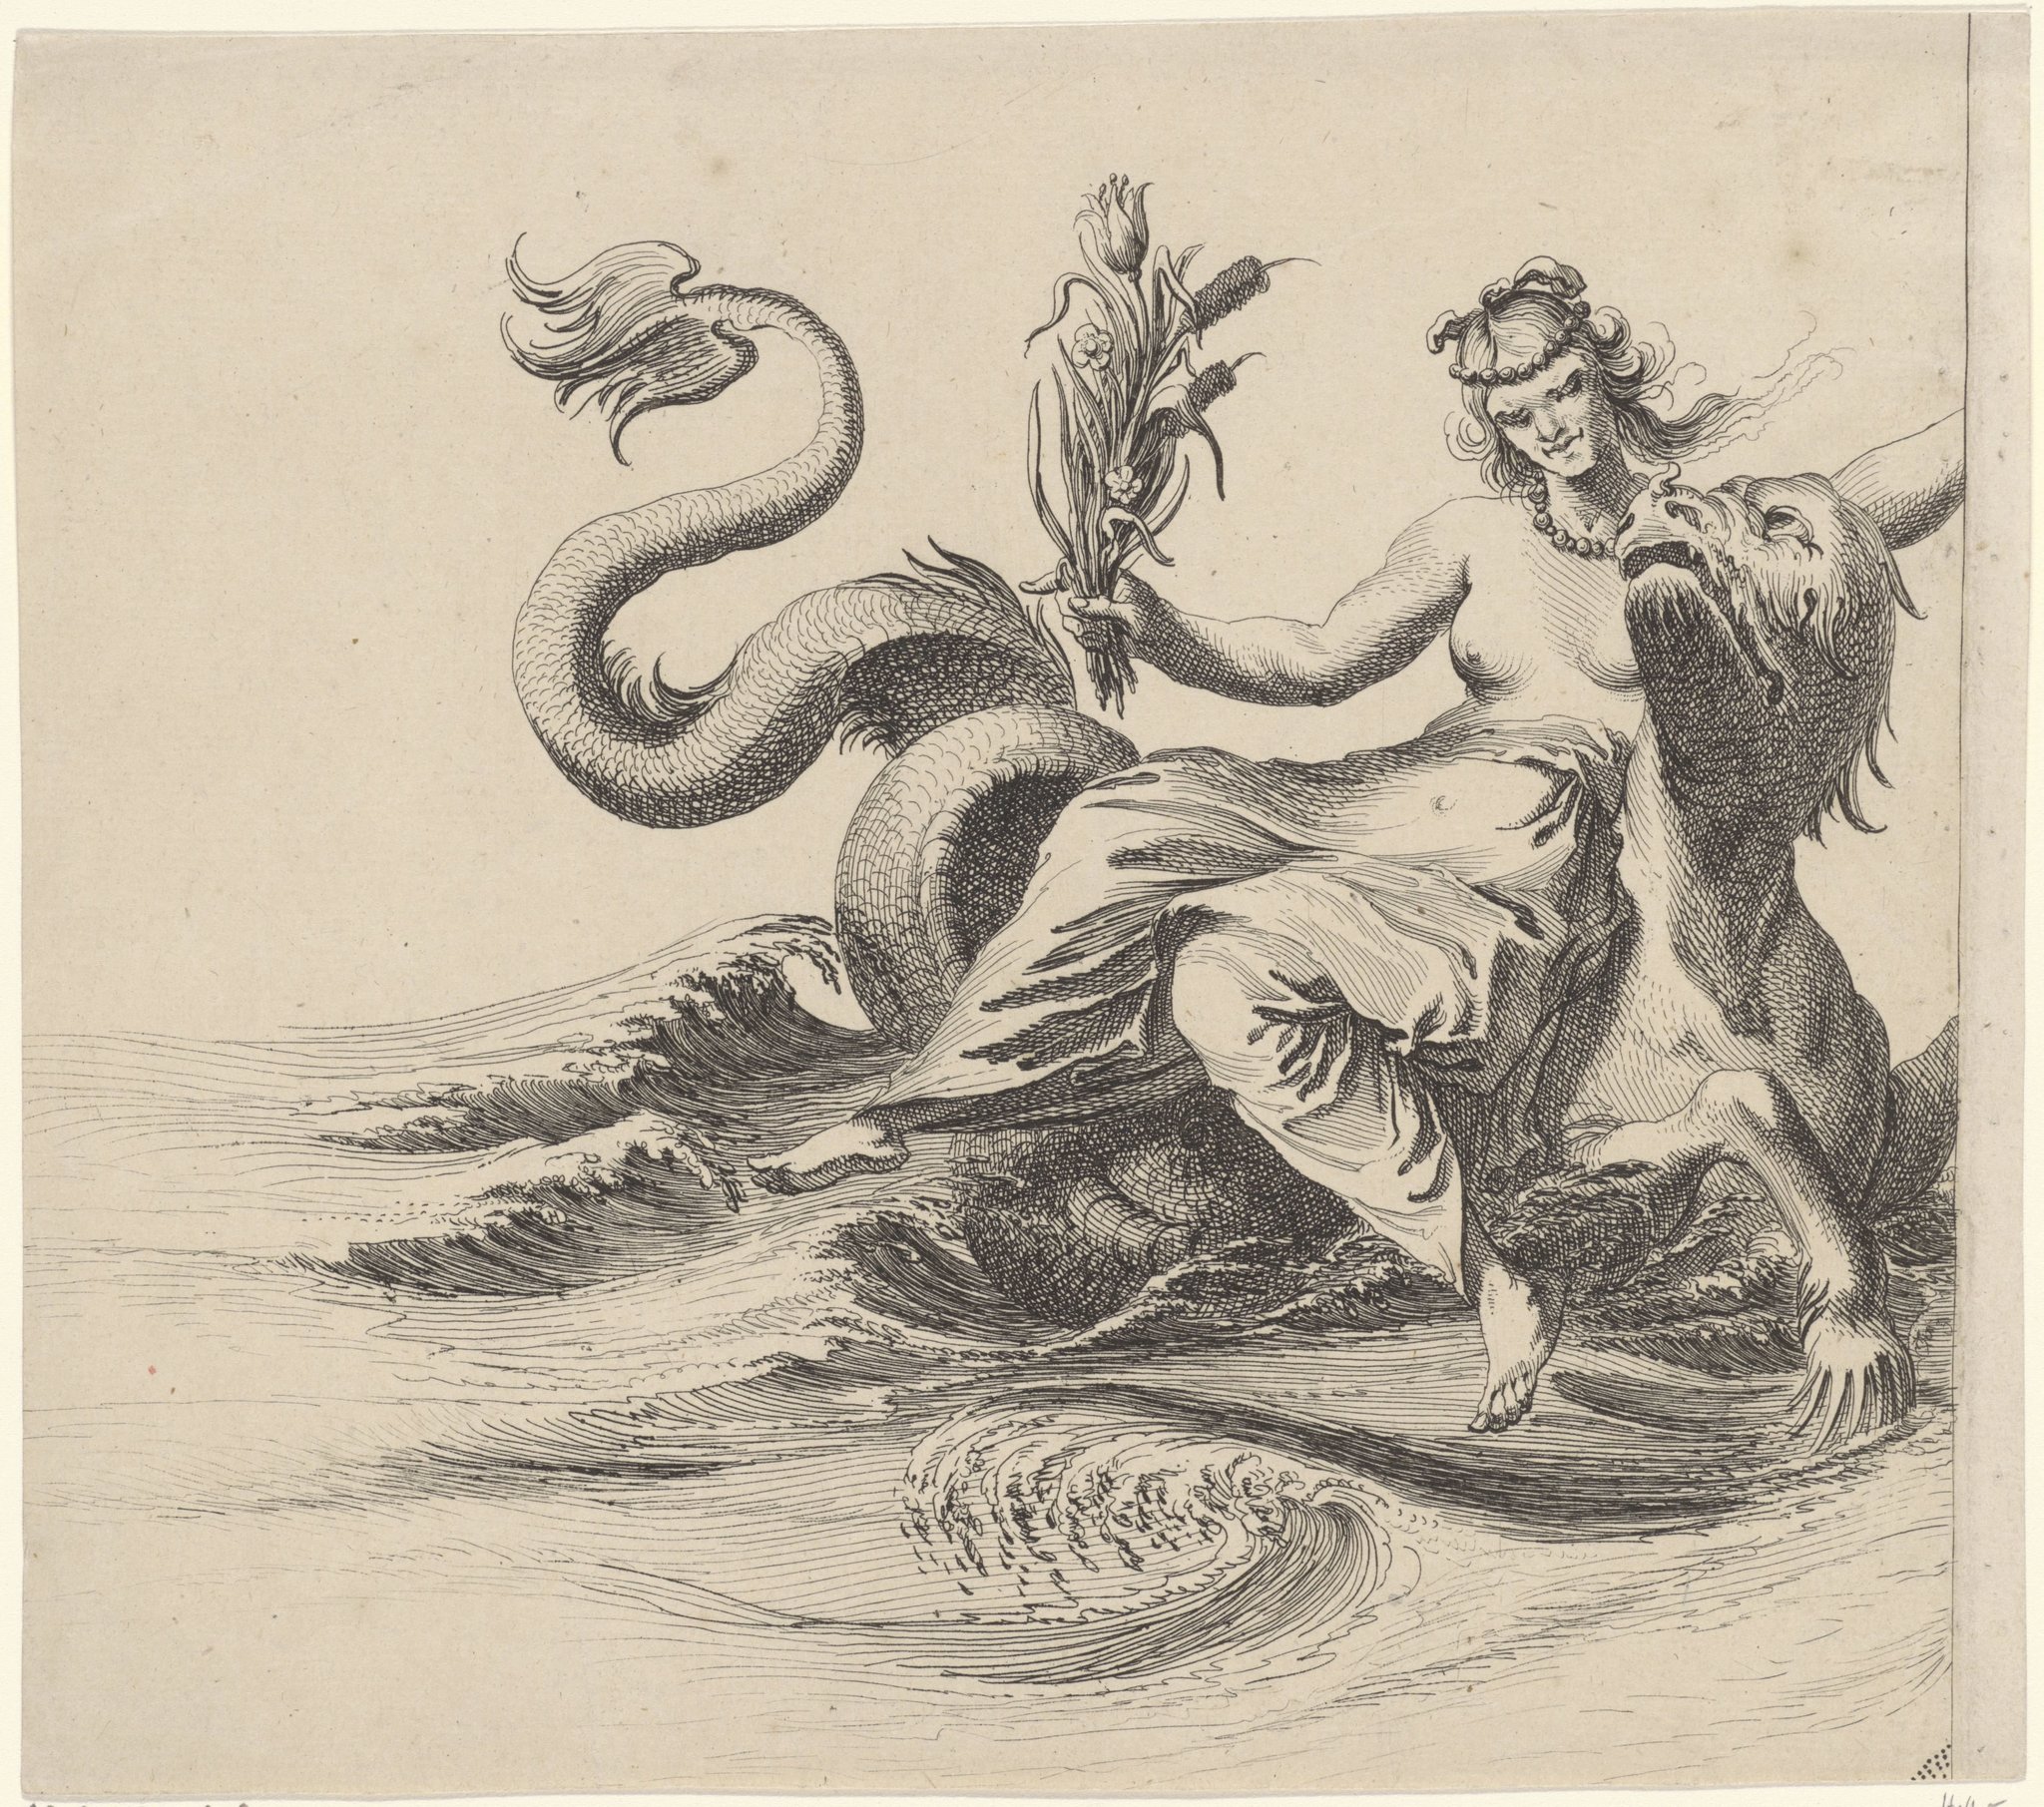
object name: print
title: Vrouw zittend op een zeedraak in de golven met bloemen in haar hand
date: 1610-1665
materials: paper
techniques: etching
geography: amsterdam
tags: monsters of the sea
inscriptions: collector's mark: Lugt 2228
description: Zie de grote wandkaart "T Graefschap Holland" (1639), uitgegeven door Jacob Aertsz Colom. Hierop komt deze vrouw samen met een man (zie RP-P-1944-411) voor, beiden gezeten op zeedieren. Zie tevens de rijk ingekleurde, tot atlas gebonden, tweede editie uit 1647.